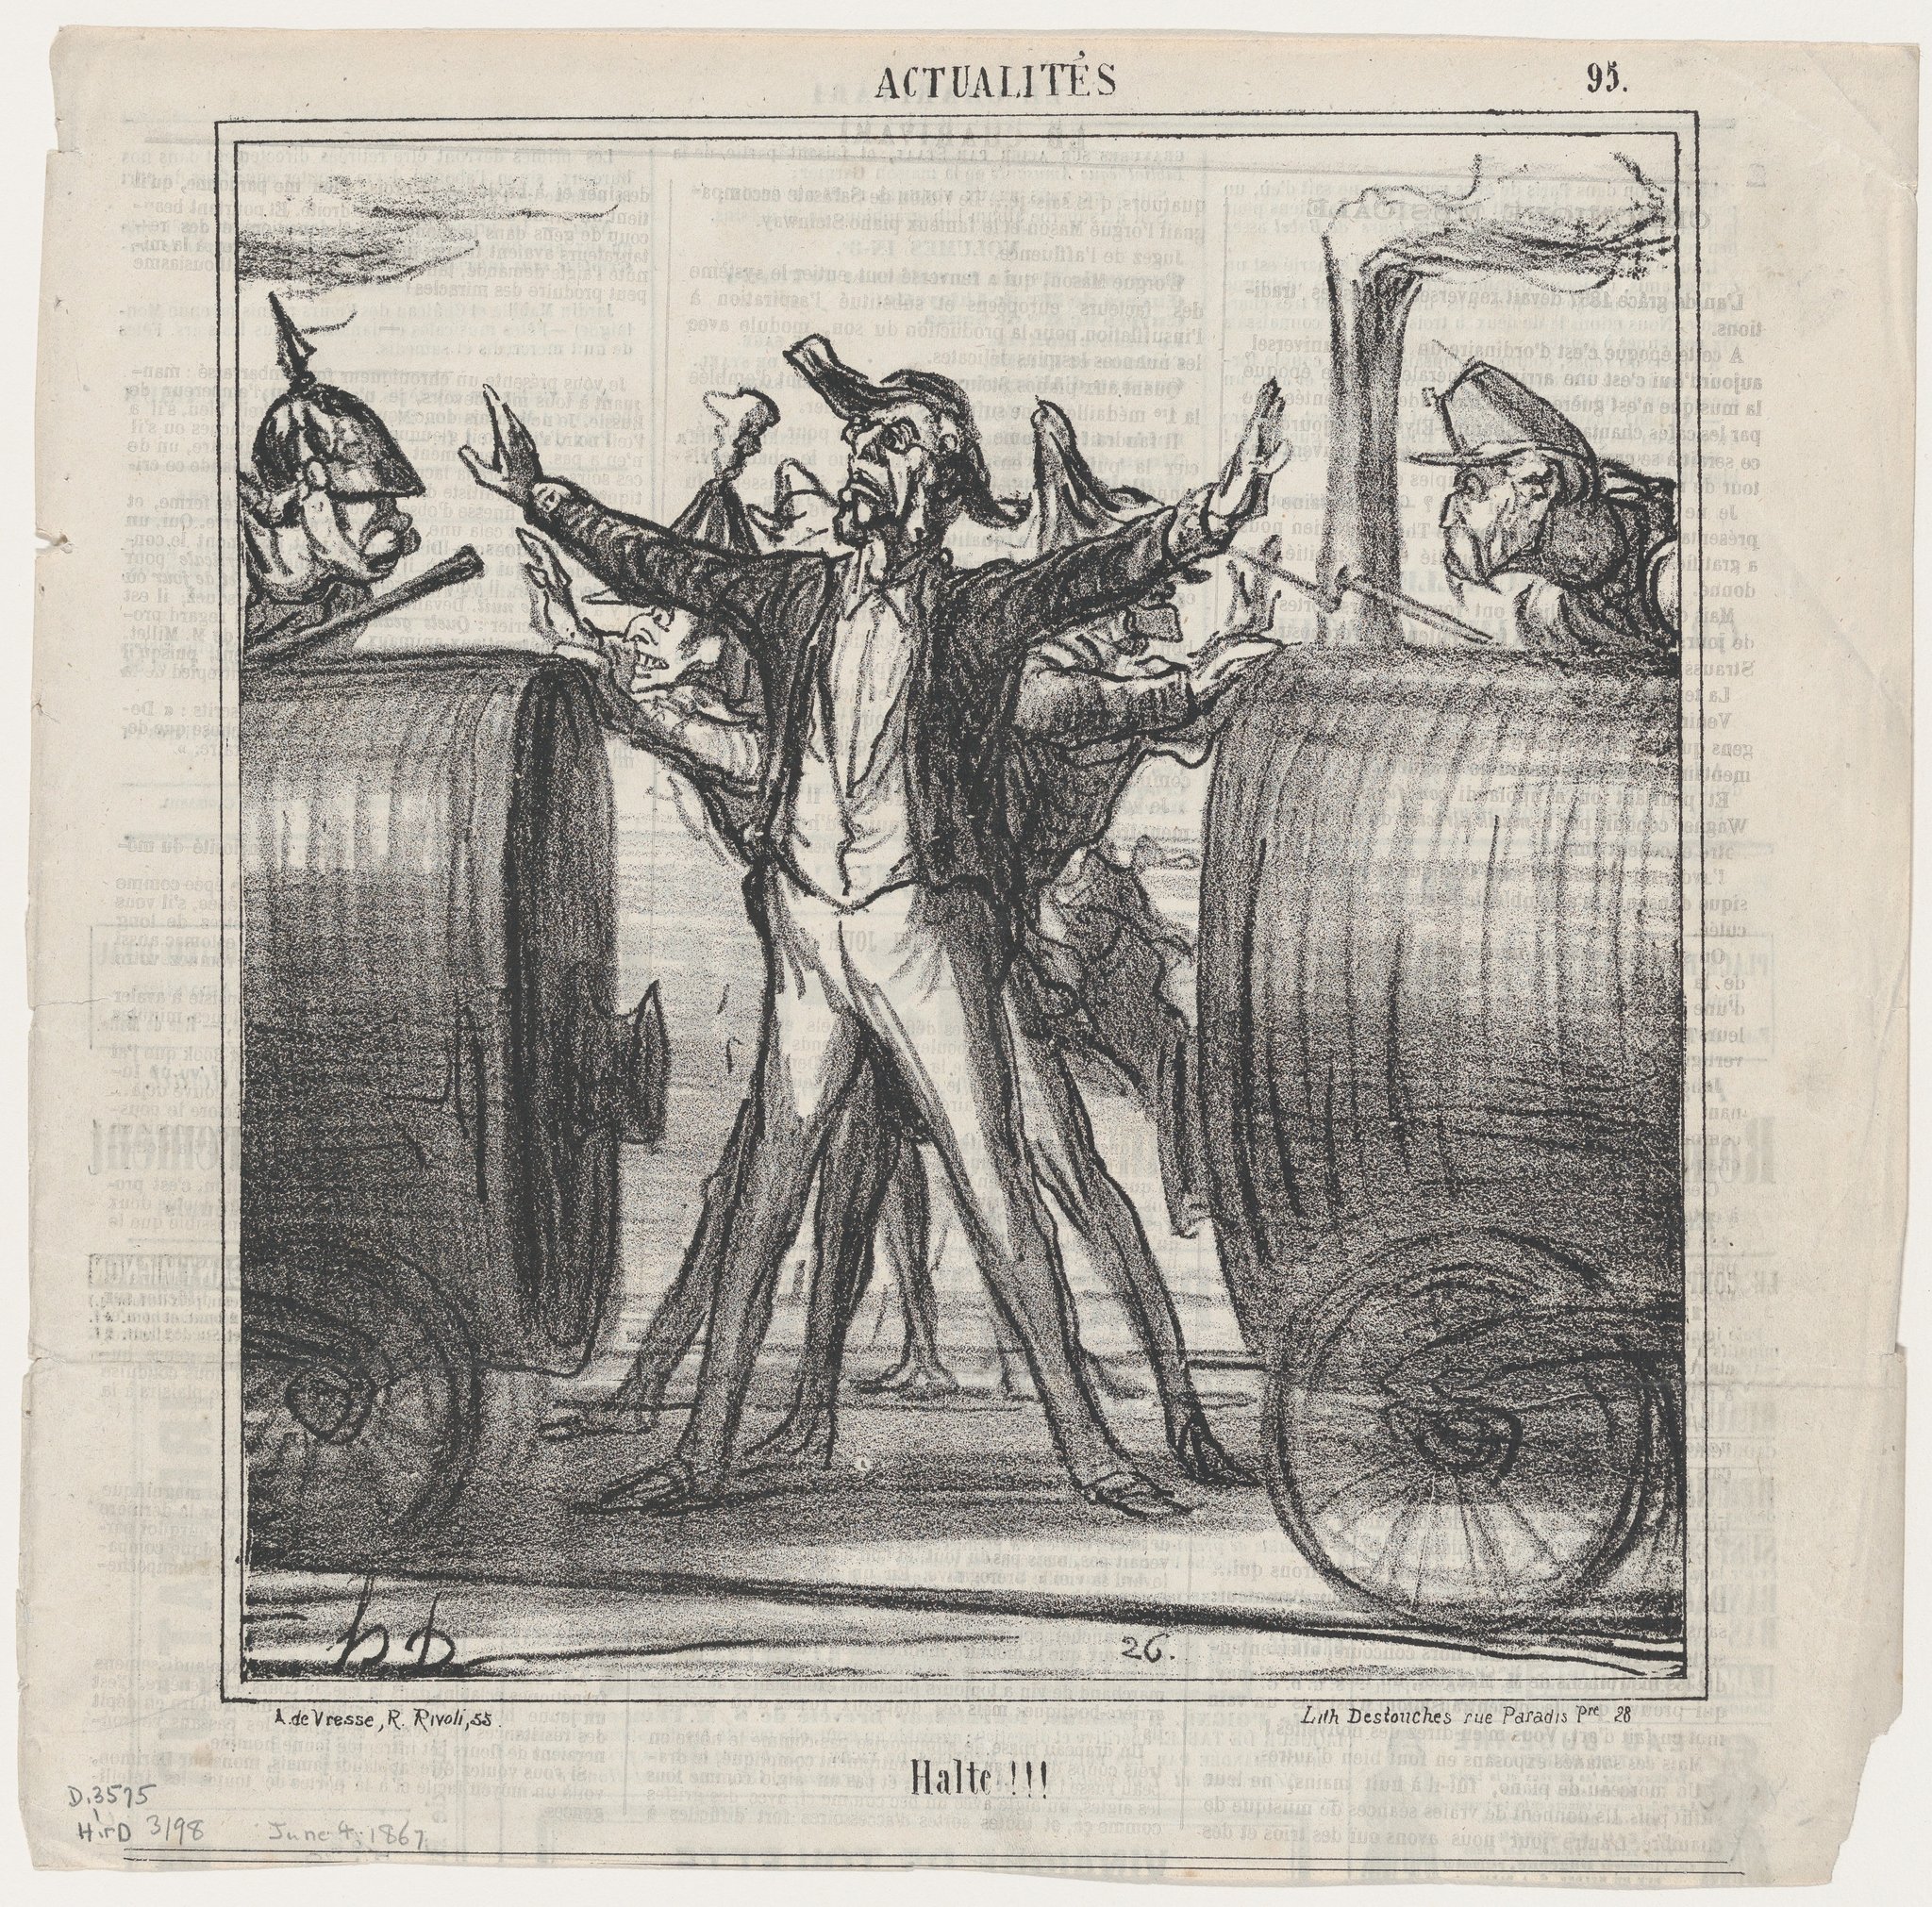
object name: print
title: Stop!!!, from 'News of the day,' published in Le Charivari, June 4, 1867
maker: honoré daumier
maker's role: artist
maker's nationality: french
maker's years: 1808-1879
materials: paper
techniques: lithograph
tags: satire,men